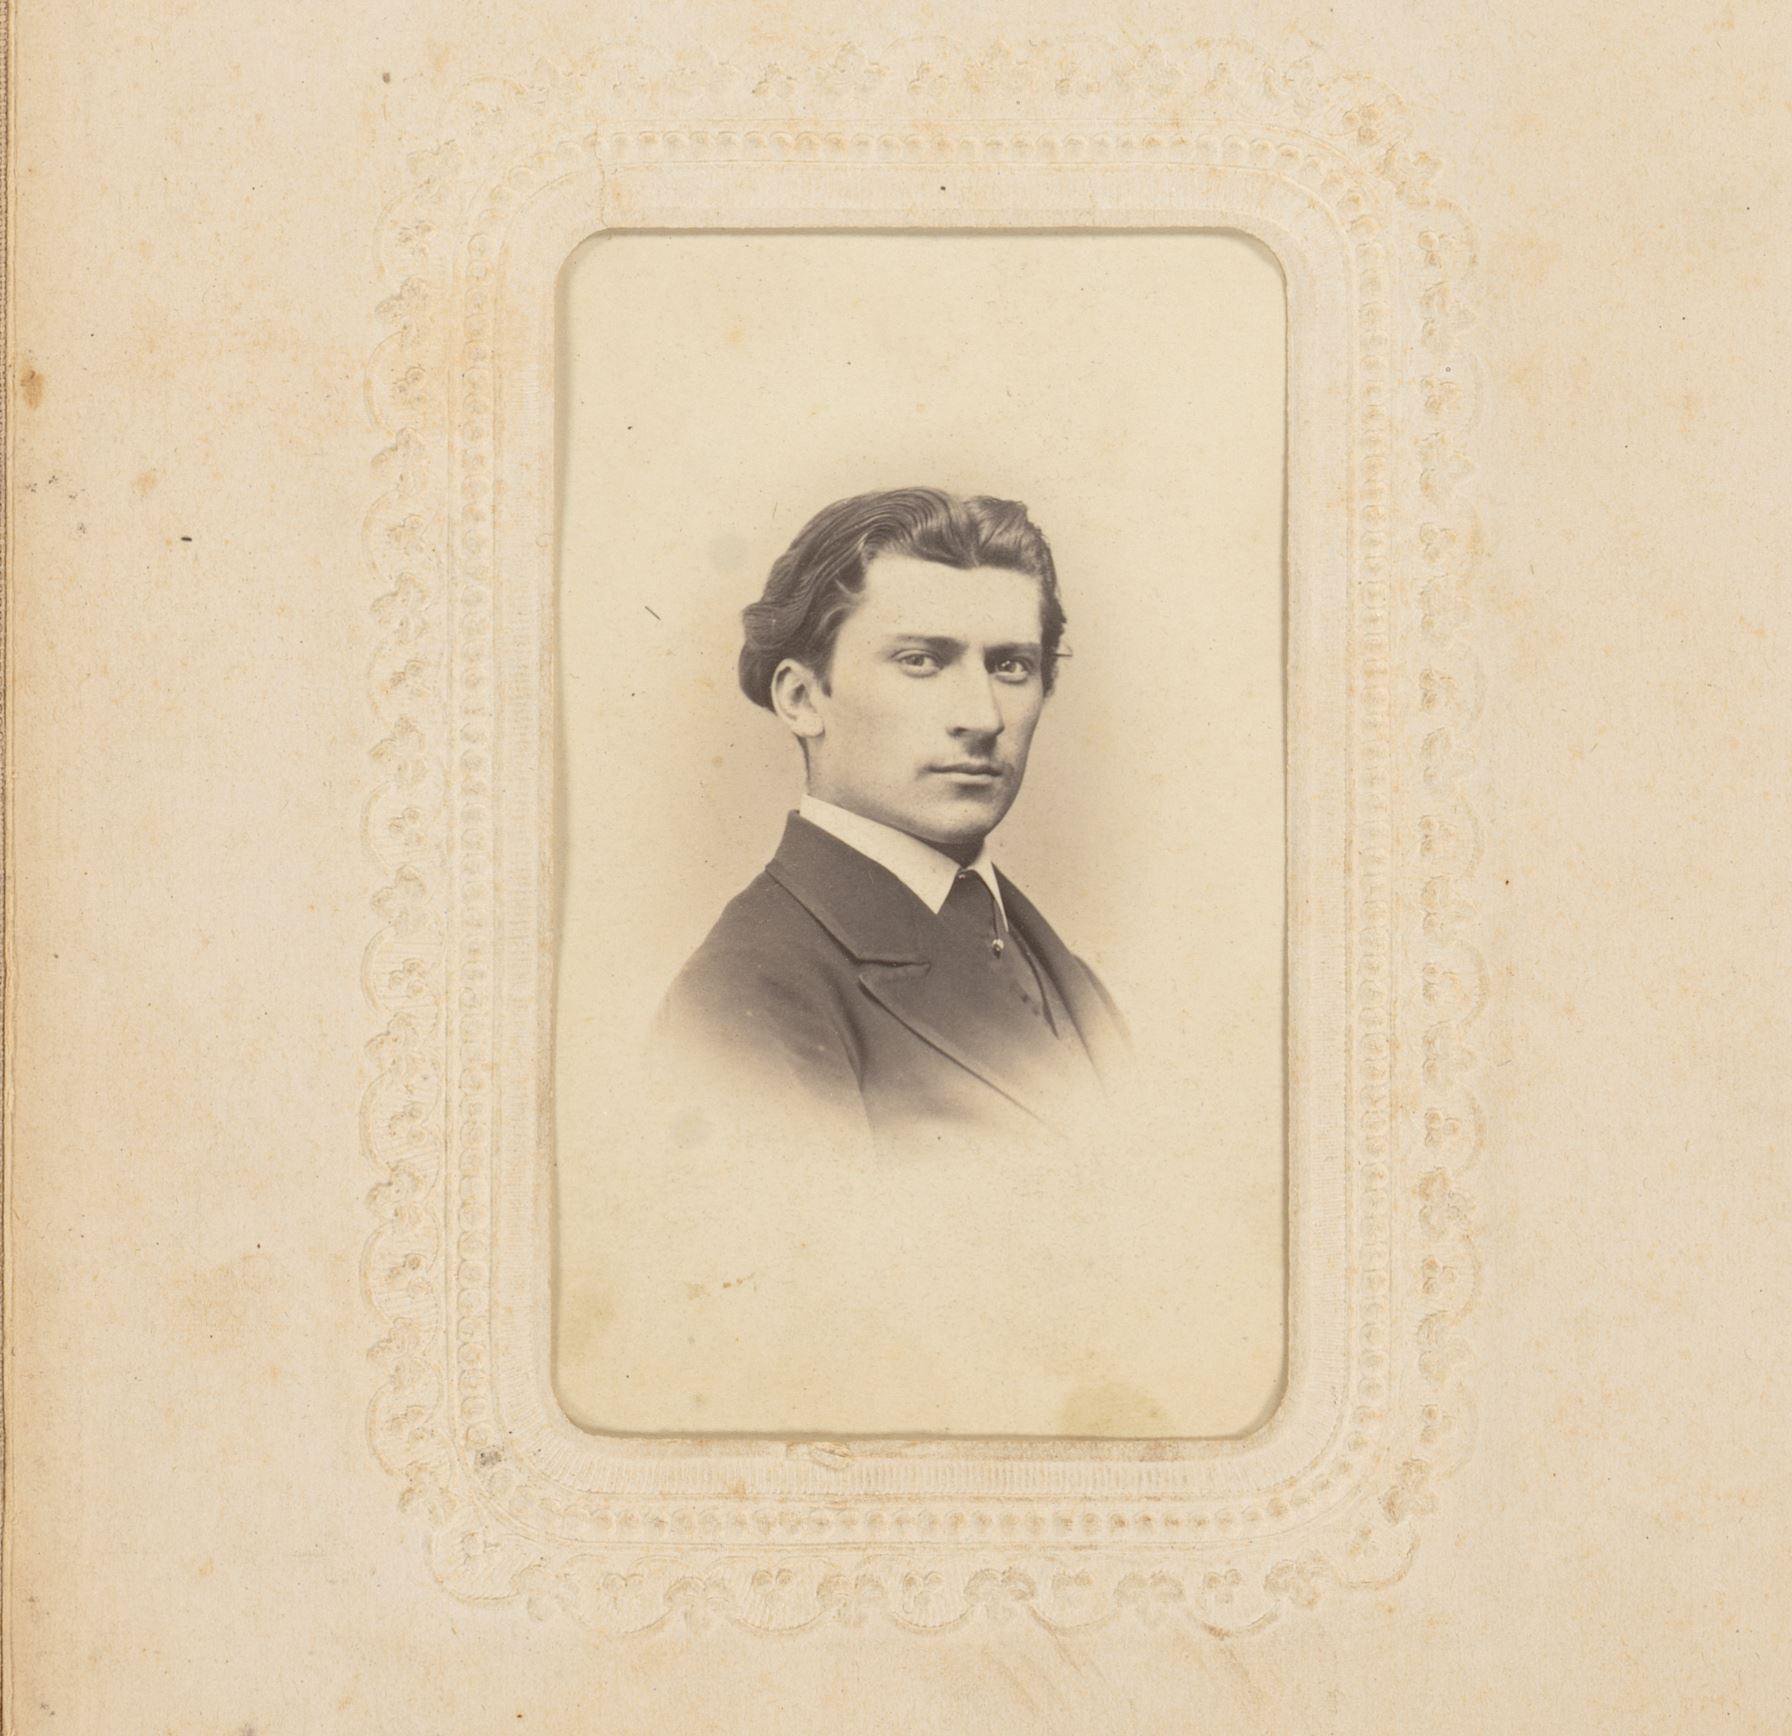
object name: carte de visite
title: Portret van een jongeman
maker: ferdinand mulnier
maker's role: painter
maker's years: 1817-1891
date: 1867-1890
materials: cardboard, photographic support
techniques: albumen print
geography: paris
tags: historical persons, youth, adolescent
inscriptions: inscription: ‘(...) photographie/ Fd. Mulnier/ breveté s.g.d.g./ 25, Boulevart des Italiens/ Paris/ Exposition universelle 1867’, annotation: ‘[...] d'amitié [...]’